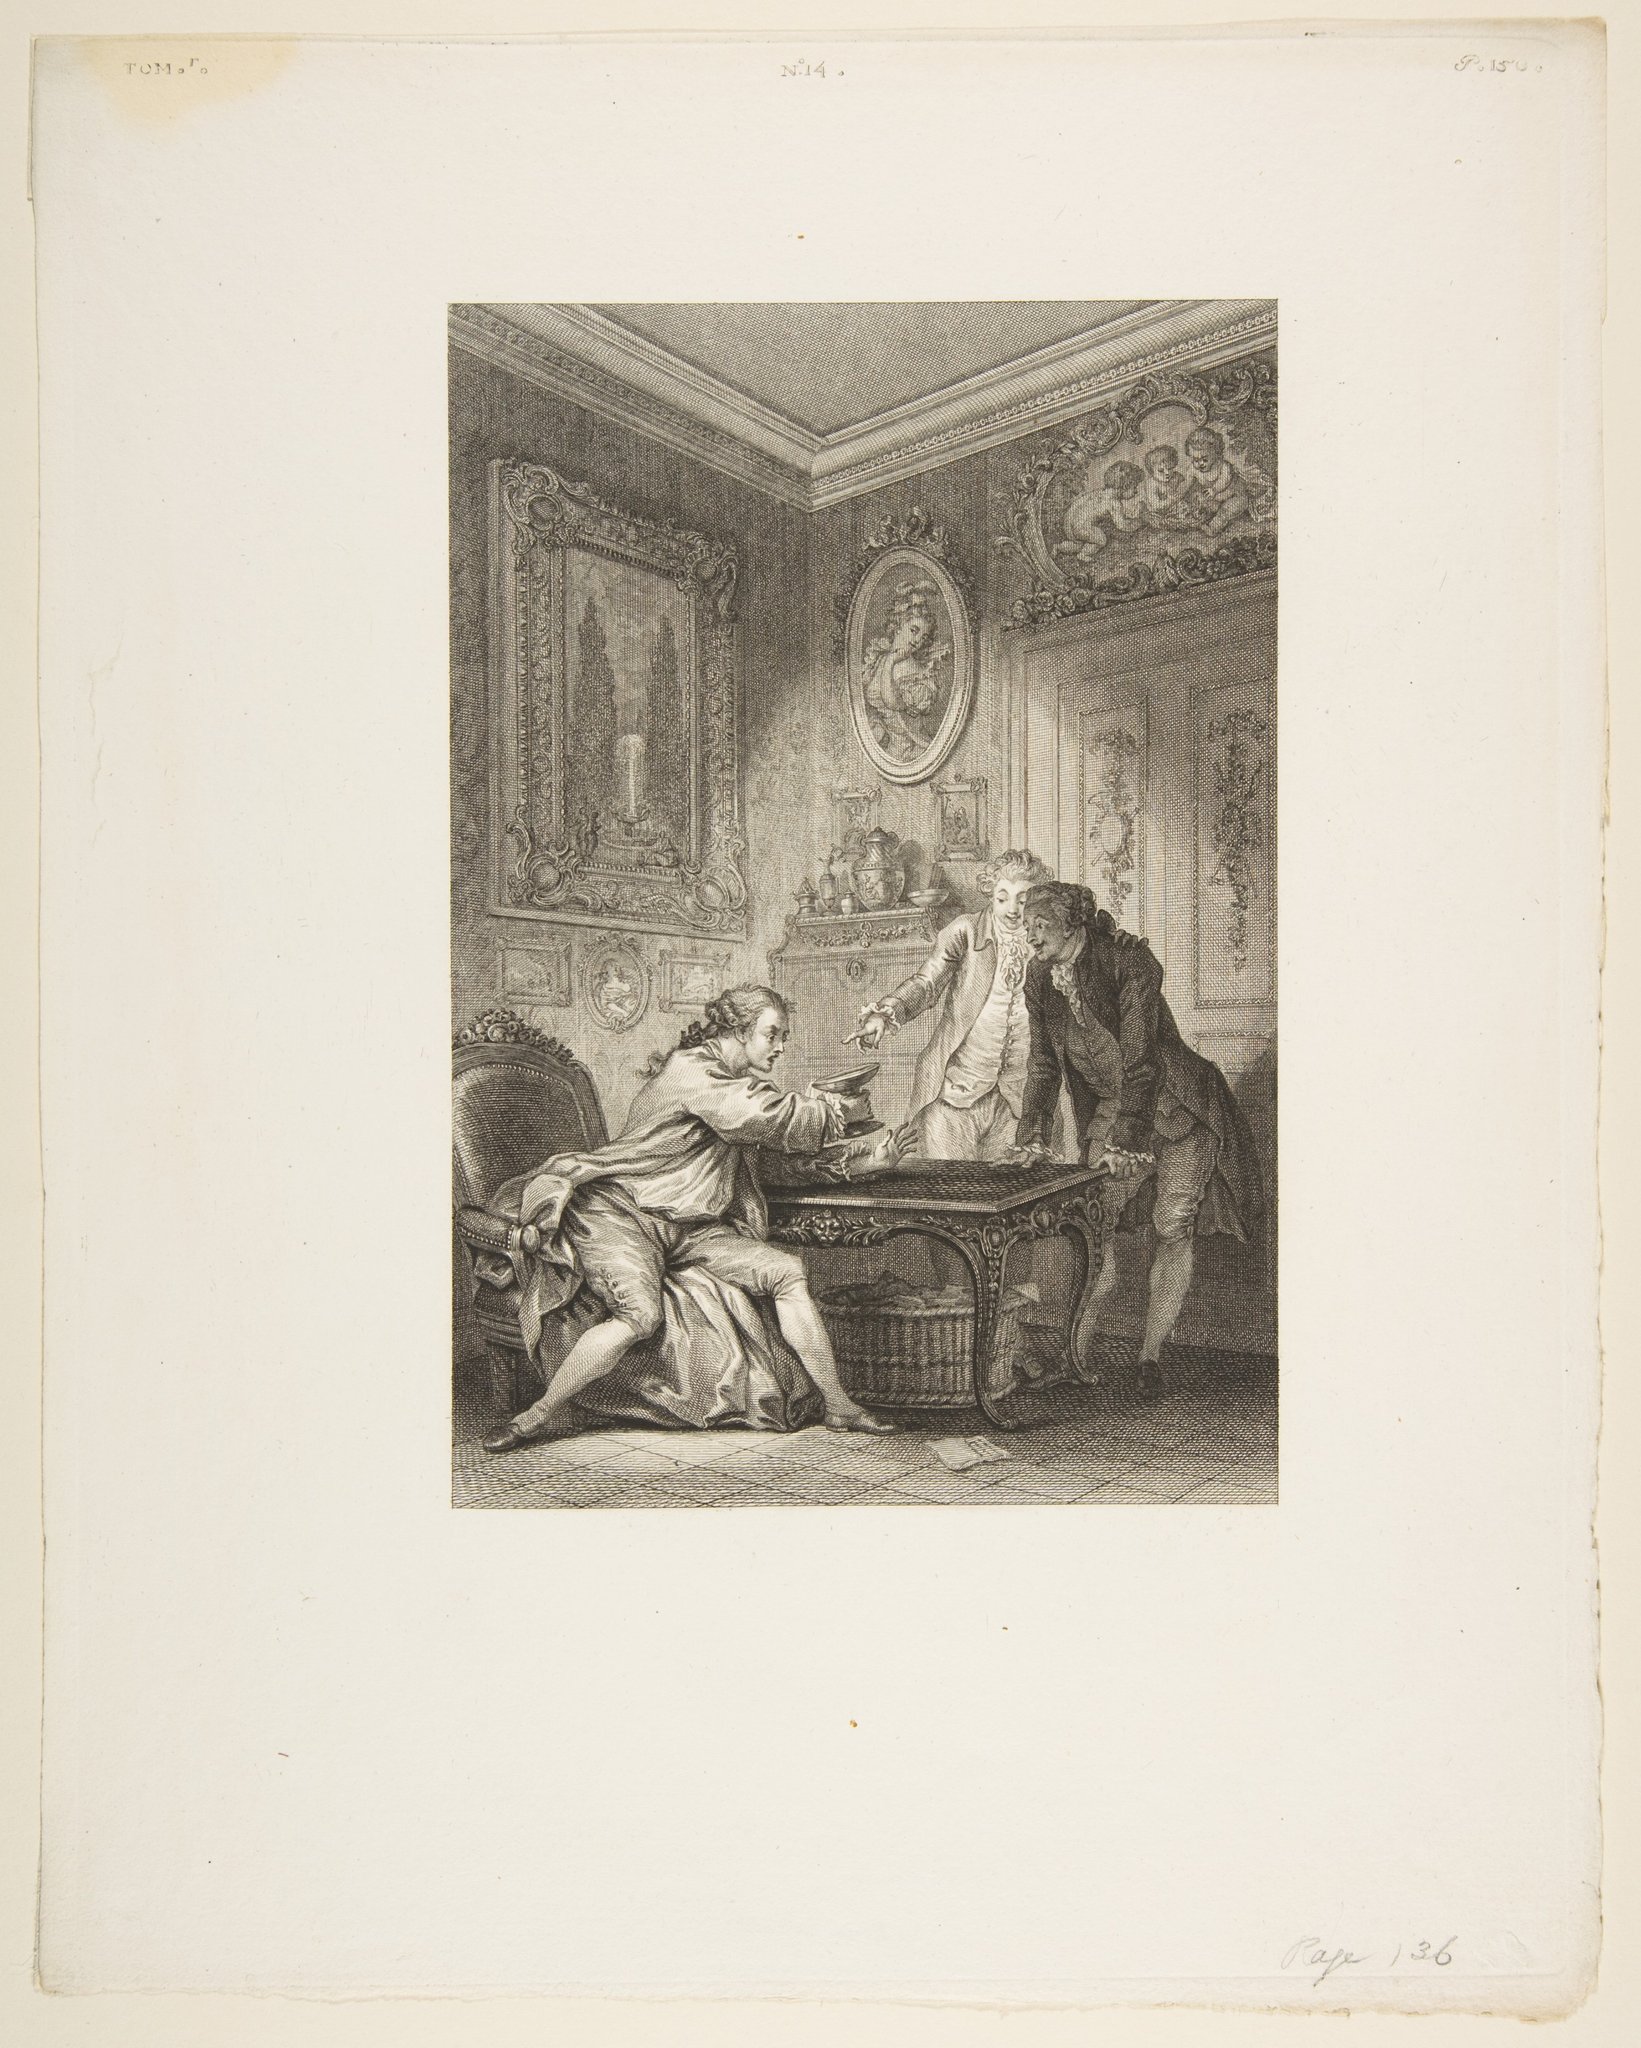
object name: print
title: La Coupe Enchantee, from Contes et nouvelles en vers par Jean de La Fontaine. A Paris, de l'imprimerie de P. Didot, l'an III de la République, 1795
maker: jean-baptiste-michel dupréel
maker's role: artist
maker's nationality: french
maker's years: 1787-1817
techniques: engraving, etching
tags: men,women,tables